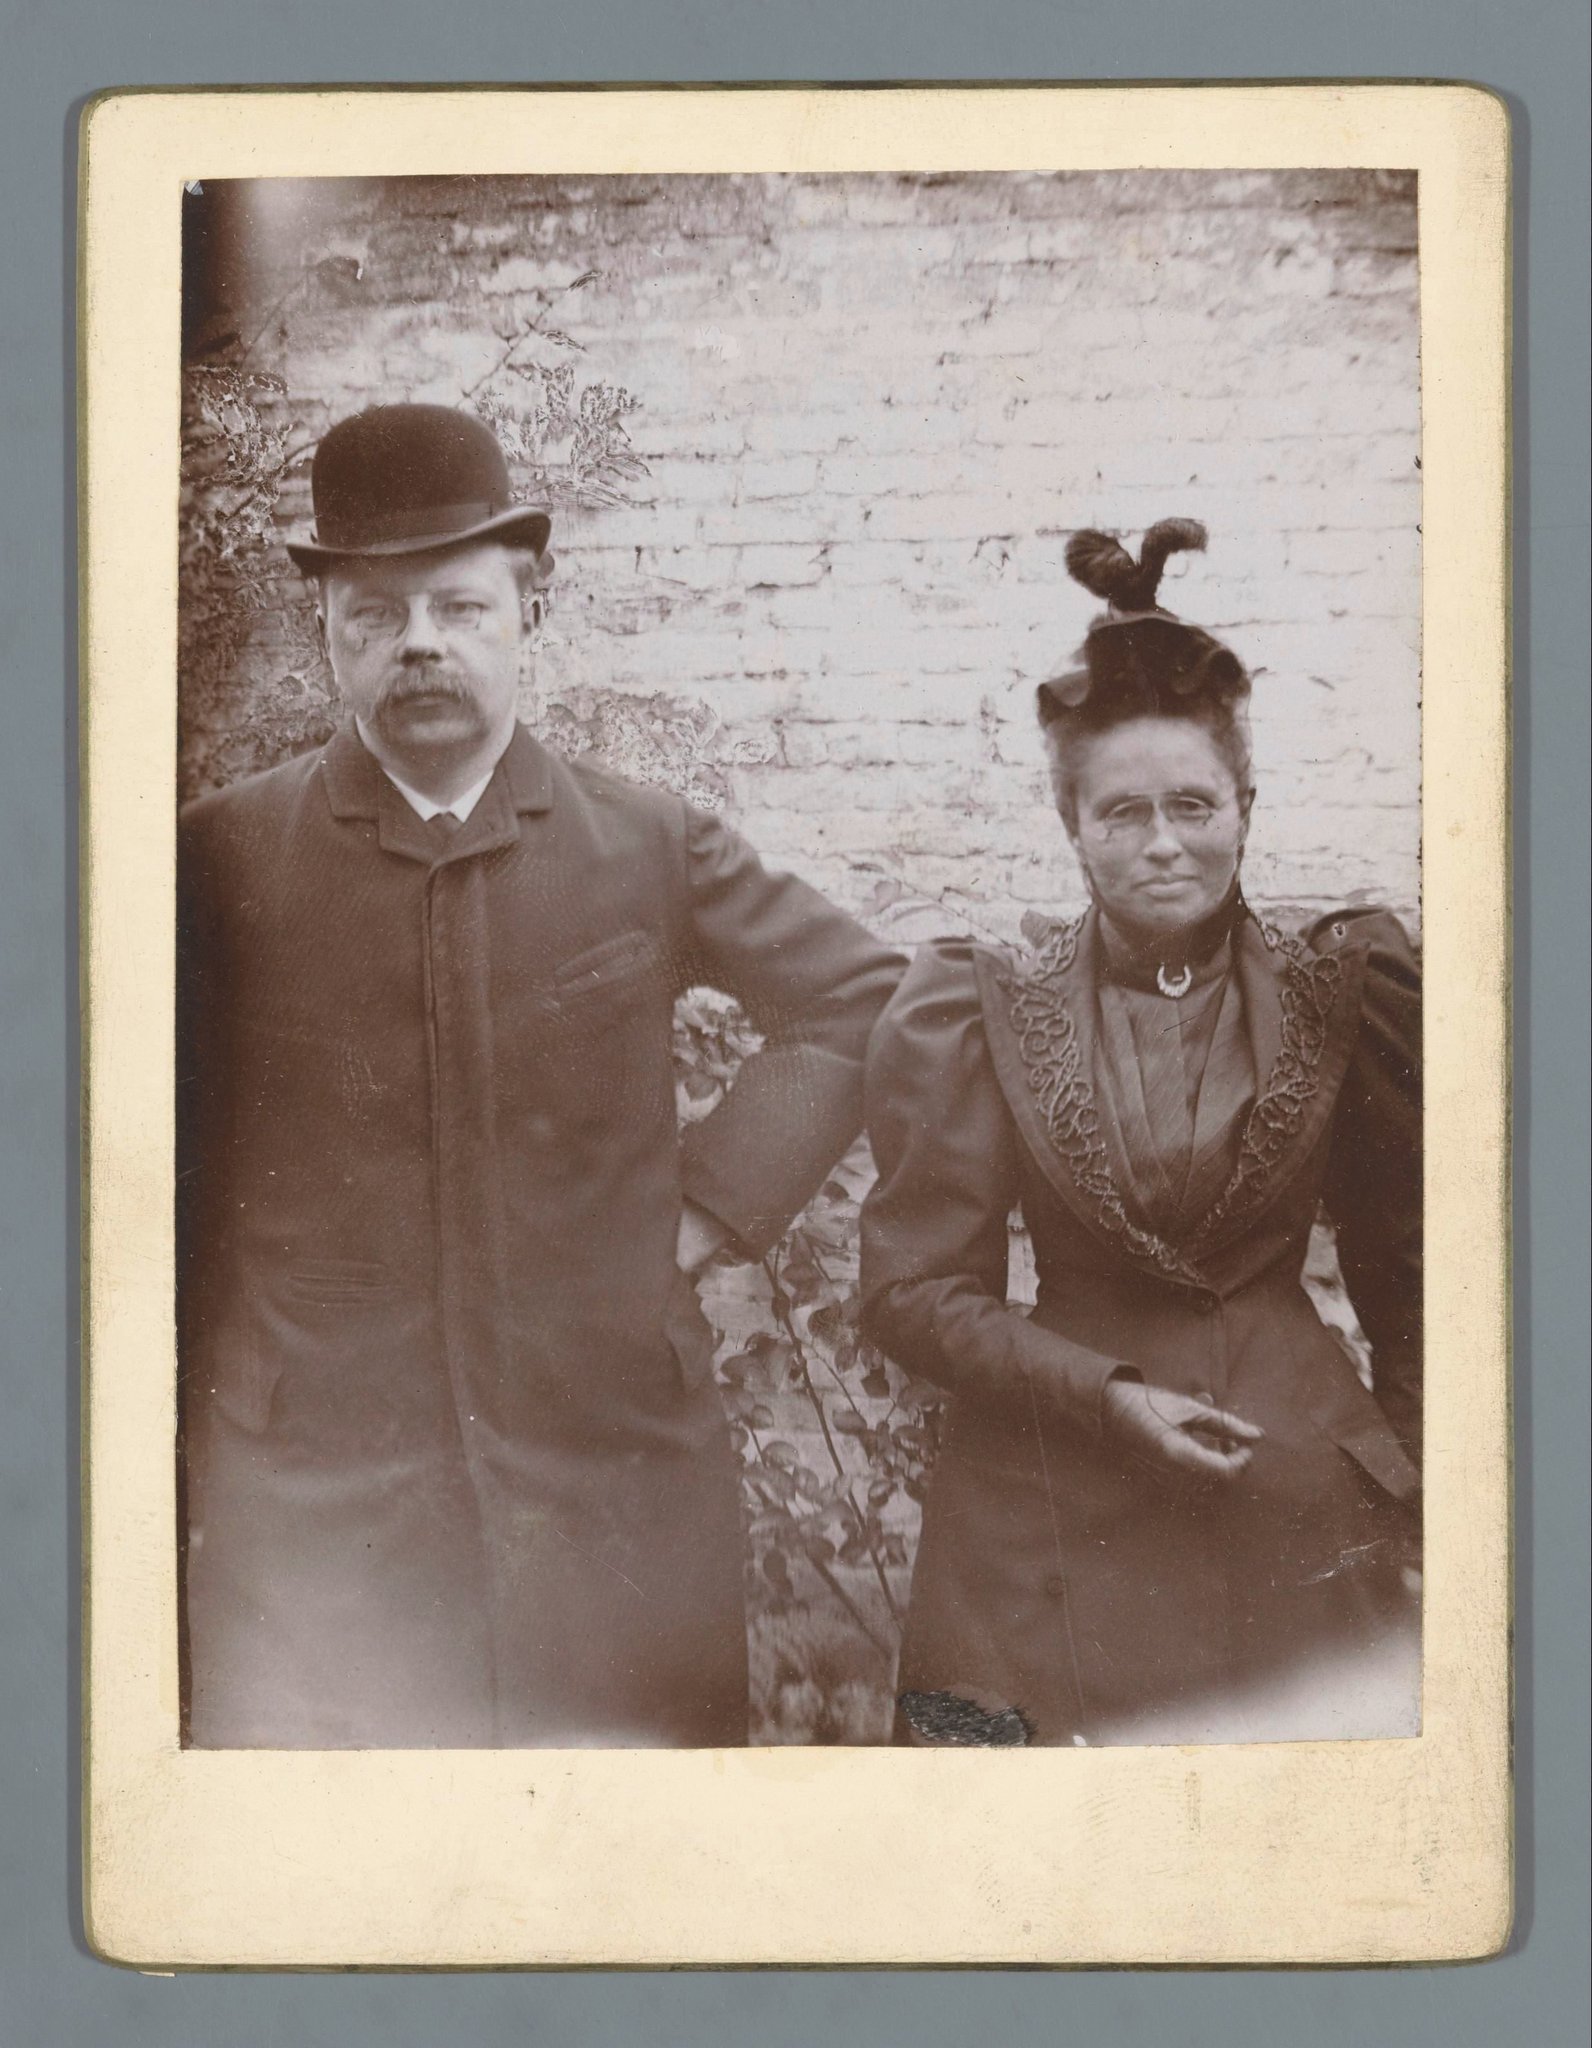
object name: photograph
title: Portret van een onbekende man en vrouw voor een stenen muur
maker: Anonymous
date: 1895-1910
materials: cardboard, photographic support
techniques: collodion silver print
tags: historical persons - bb - woman, fence, wall, paling, historical persons